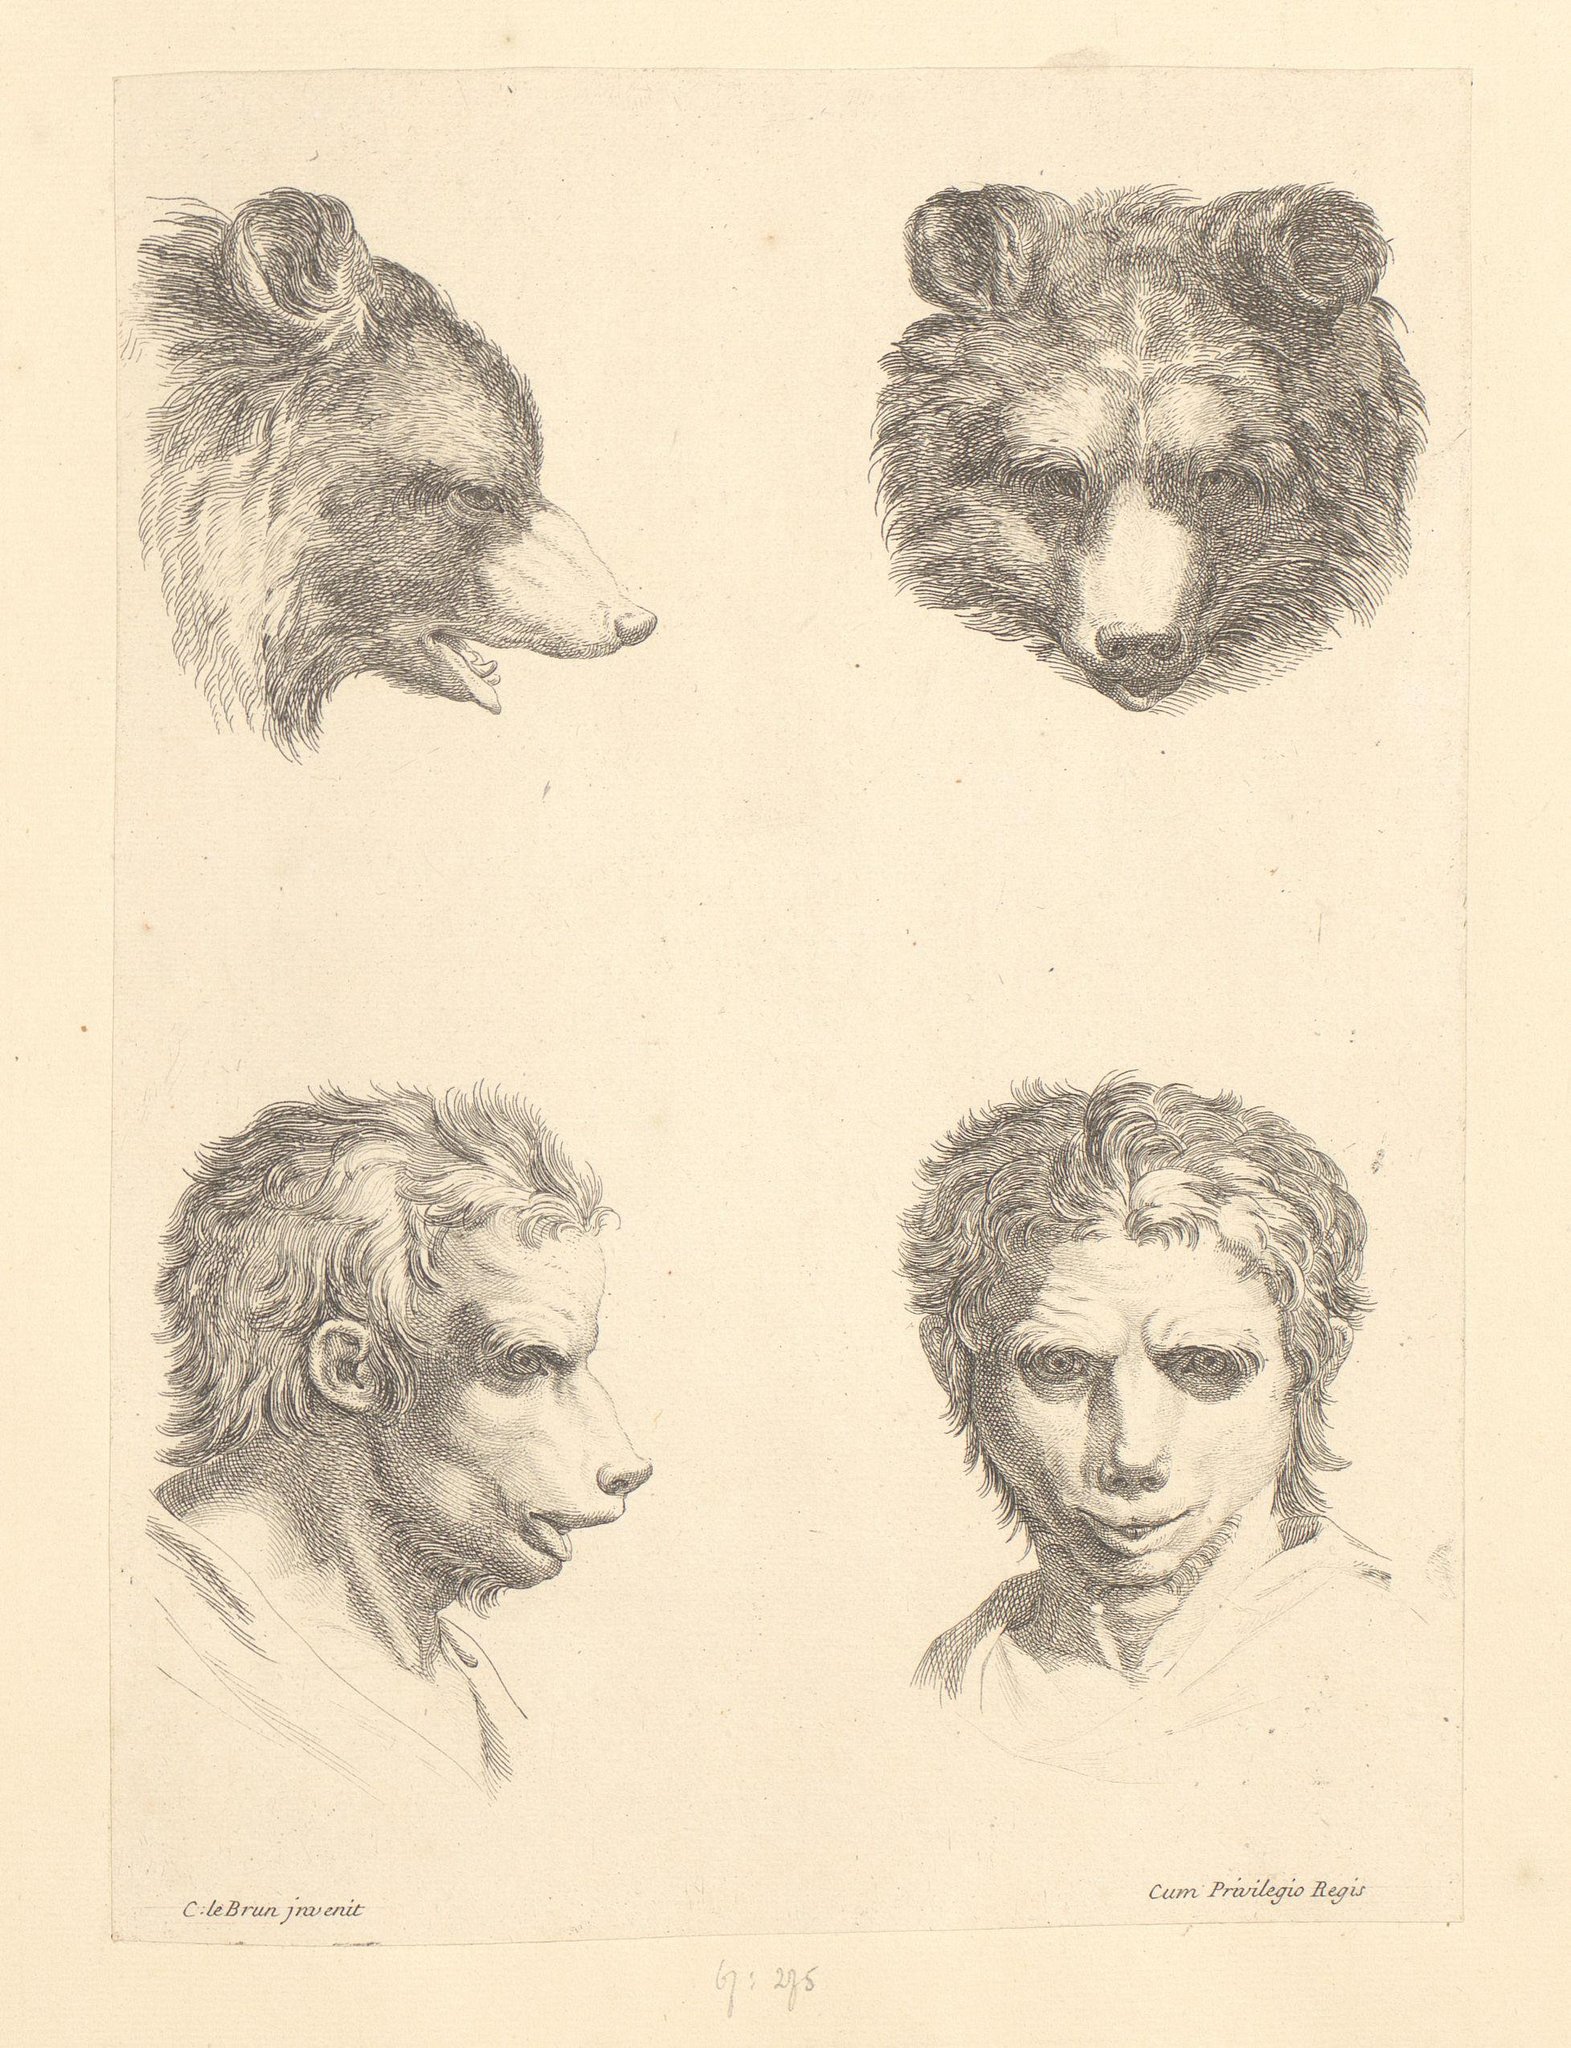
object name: album leaf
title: Livre de portraiture pour ceux qui commencent a dessiner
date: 1700-1725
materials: paper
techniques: etching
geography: paris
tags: face, beasts of prey, predatory animals: bear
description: Deze prent maakt deel uit van de serie 'Livre de portraiture', die weer onderdeel is van de grotere reeks 'Oeuvre de Charles le Brun'.